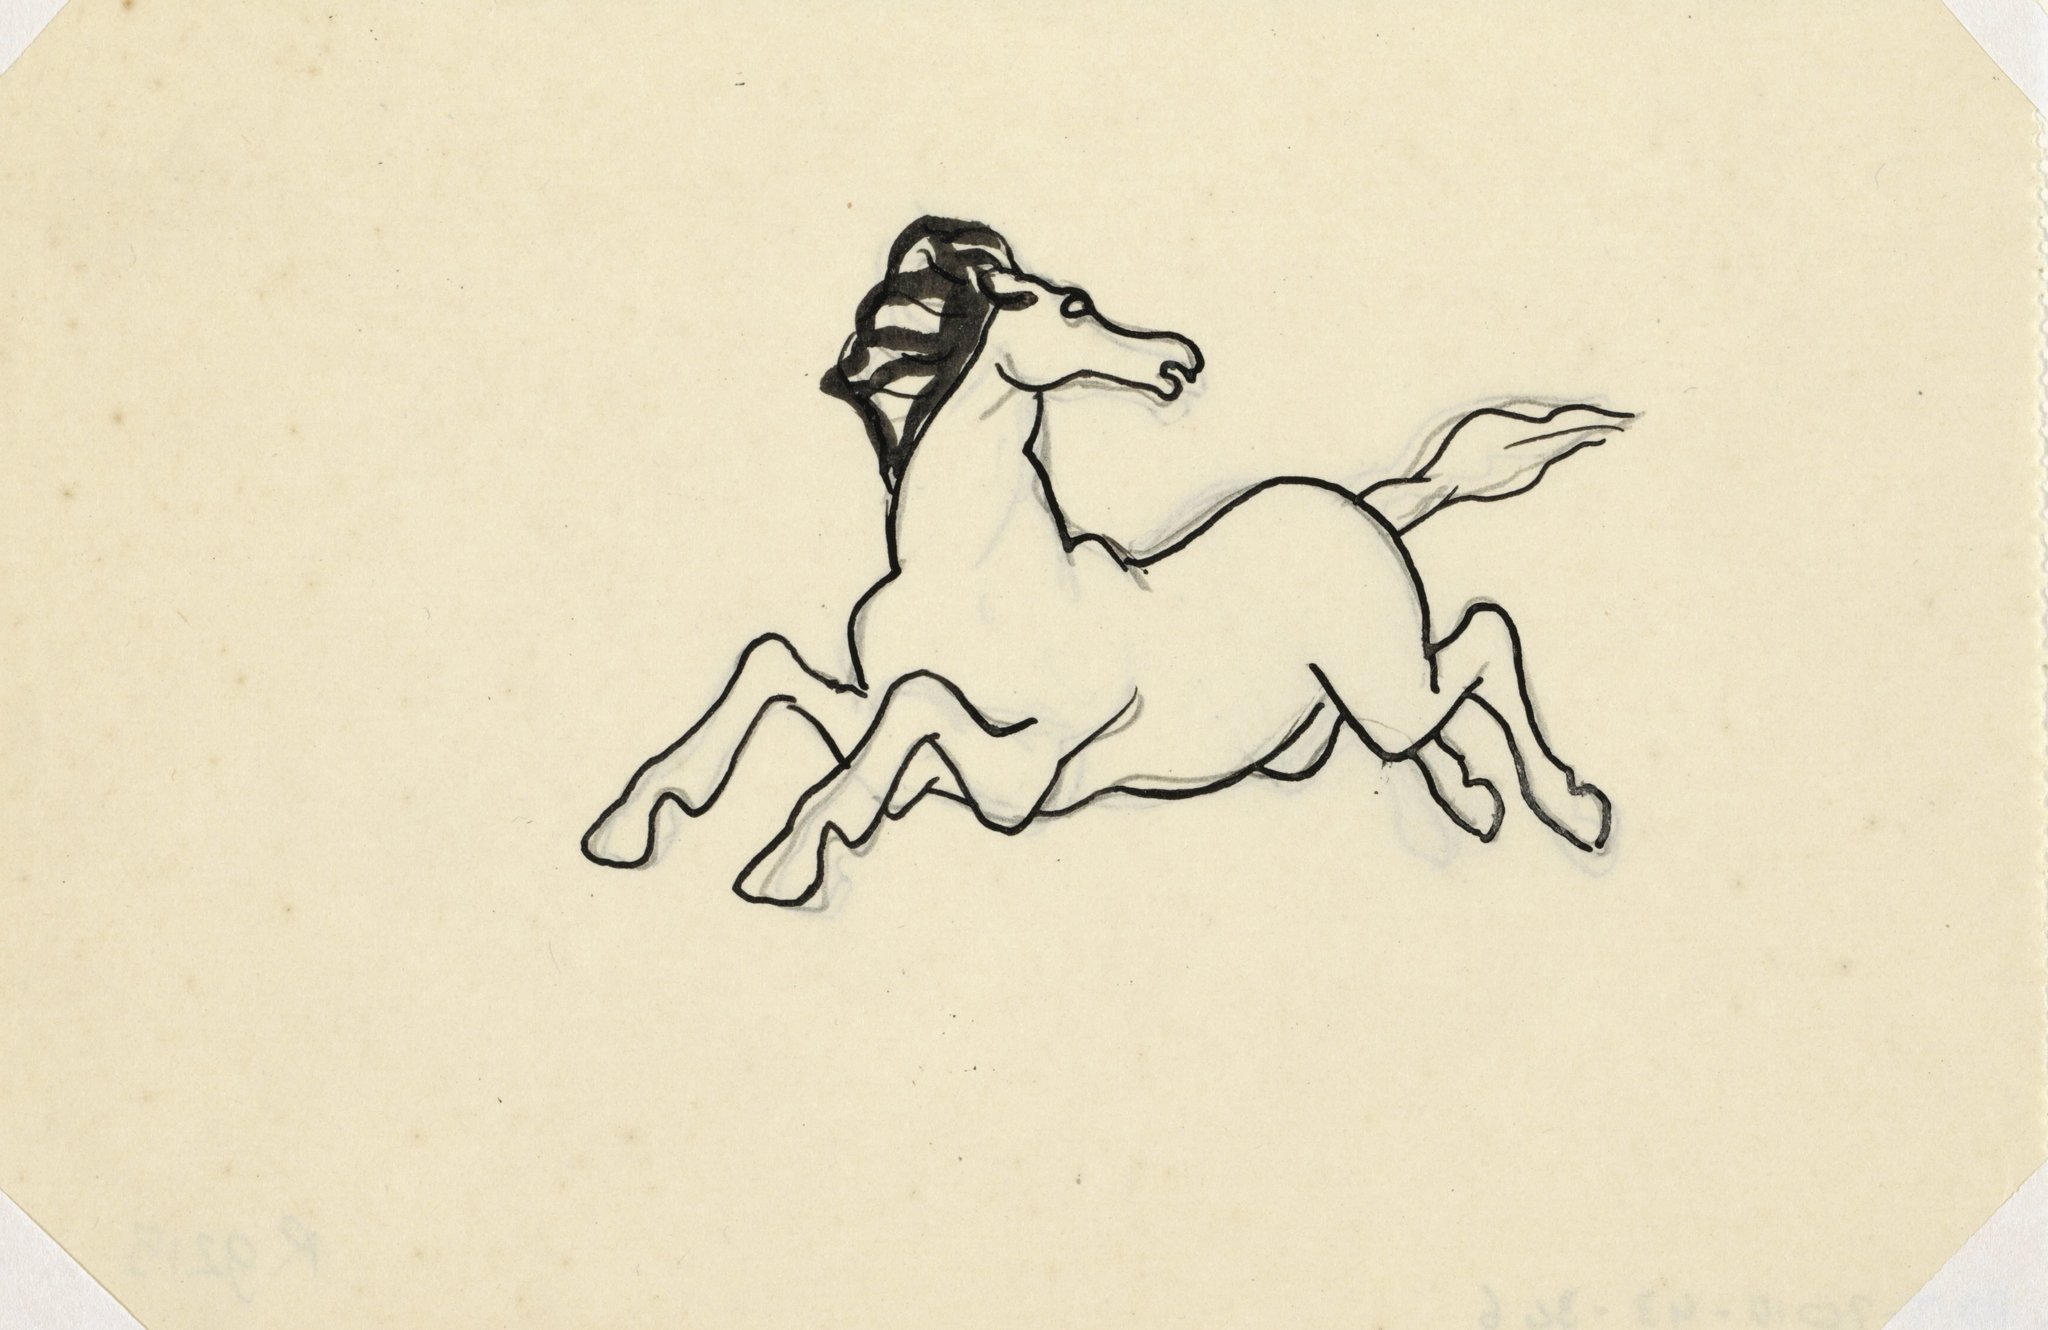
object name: drawing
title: Zonder titel Paard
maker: leo gestel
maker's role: draughtsman, print maker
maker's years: 1881-1941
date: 1937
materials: ink, paper, pencil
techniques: brush, pen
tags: horse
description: De voormalige titel is door het Rijksmuseum overgenomen van het Instituut Collectie Nederland.